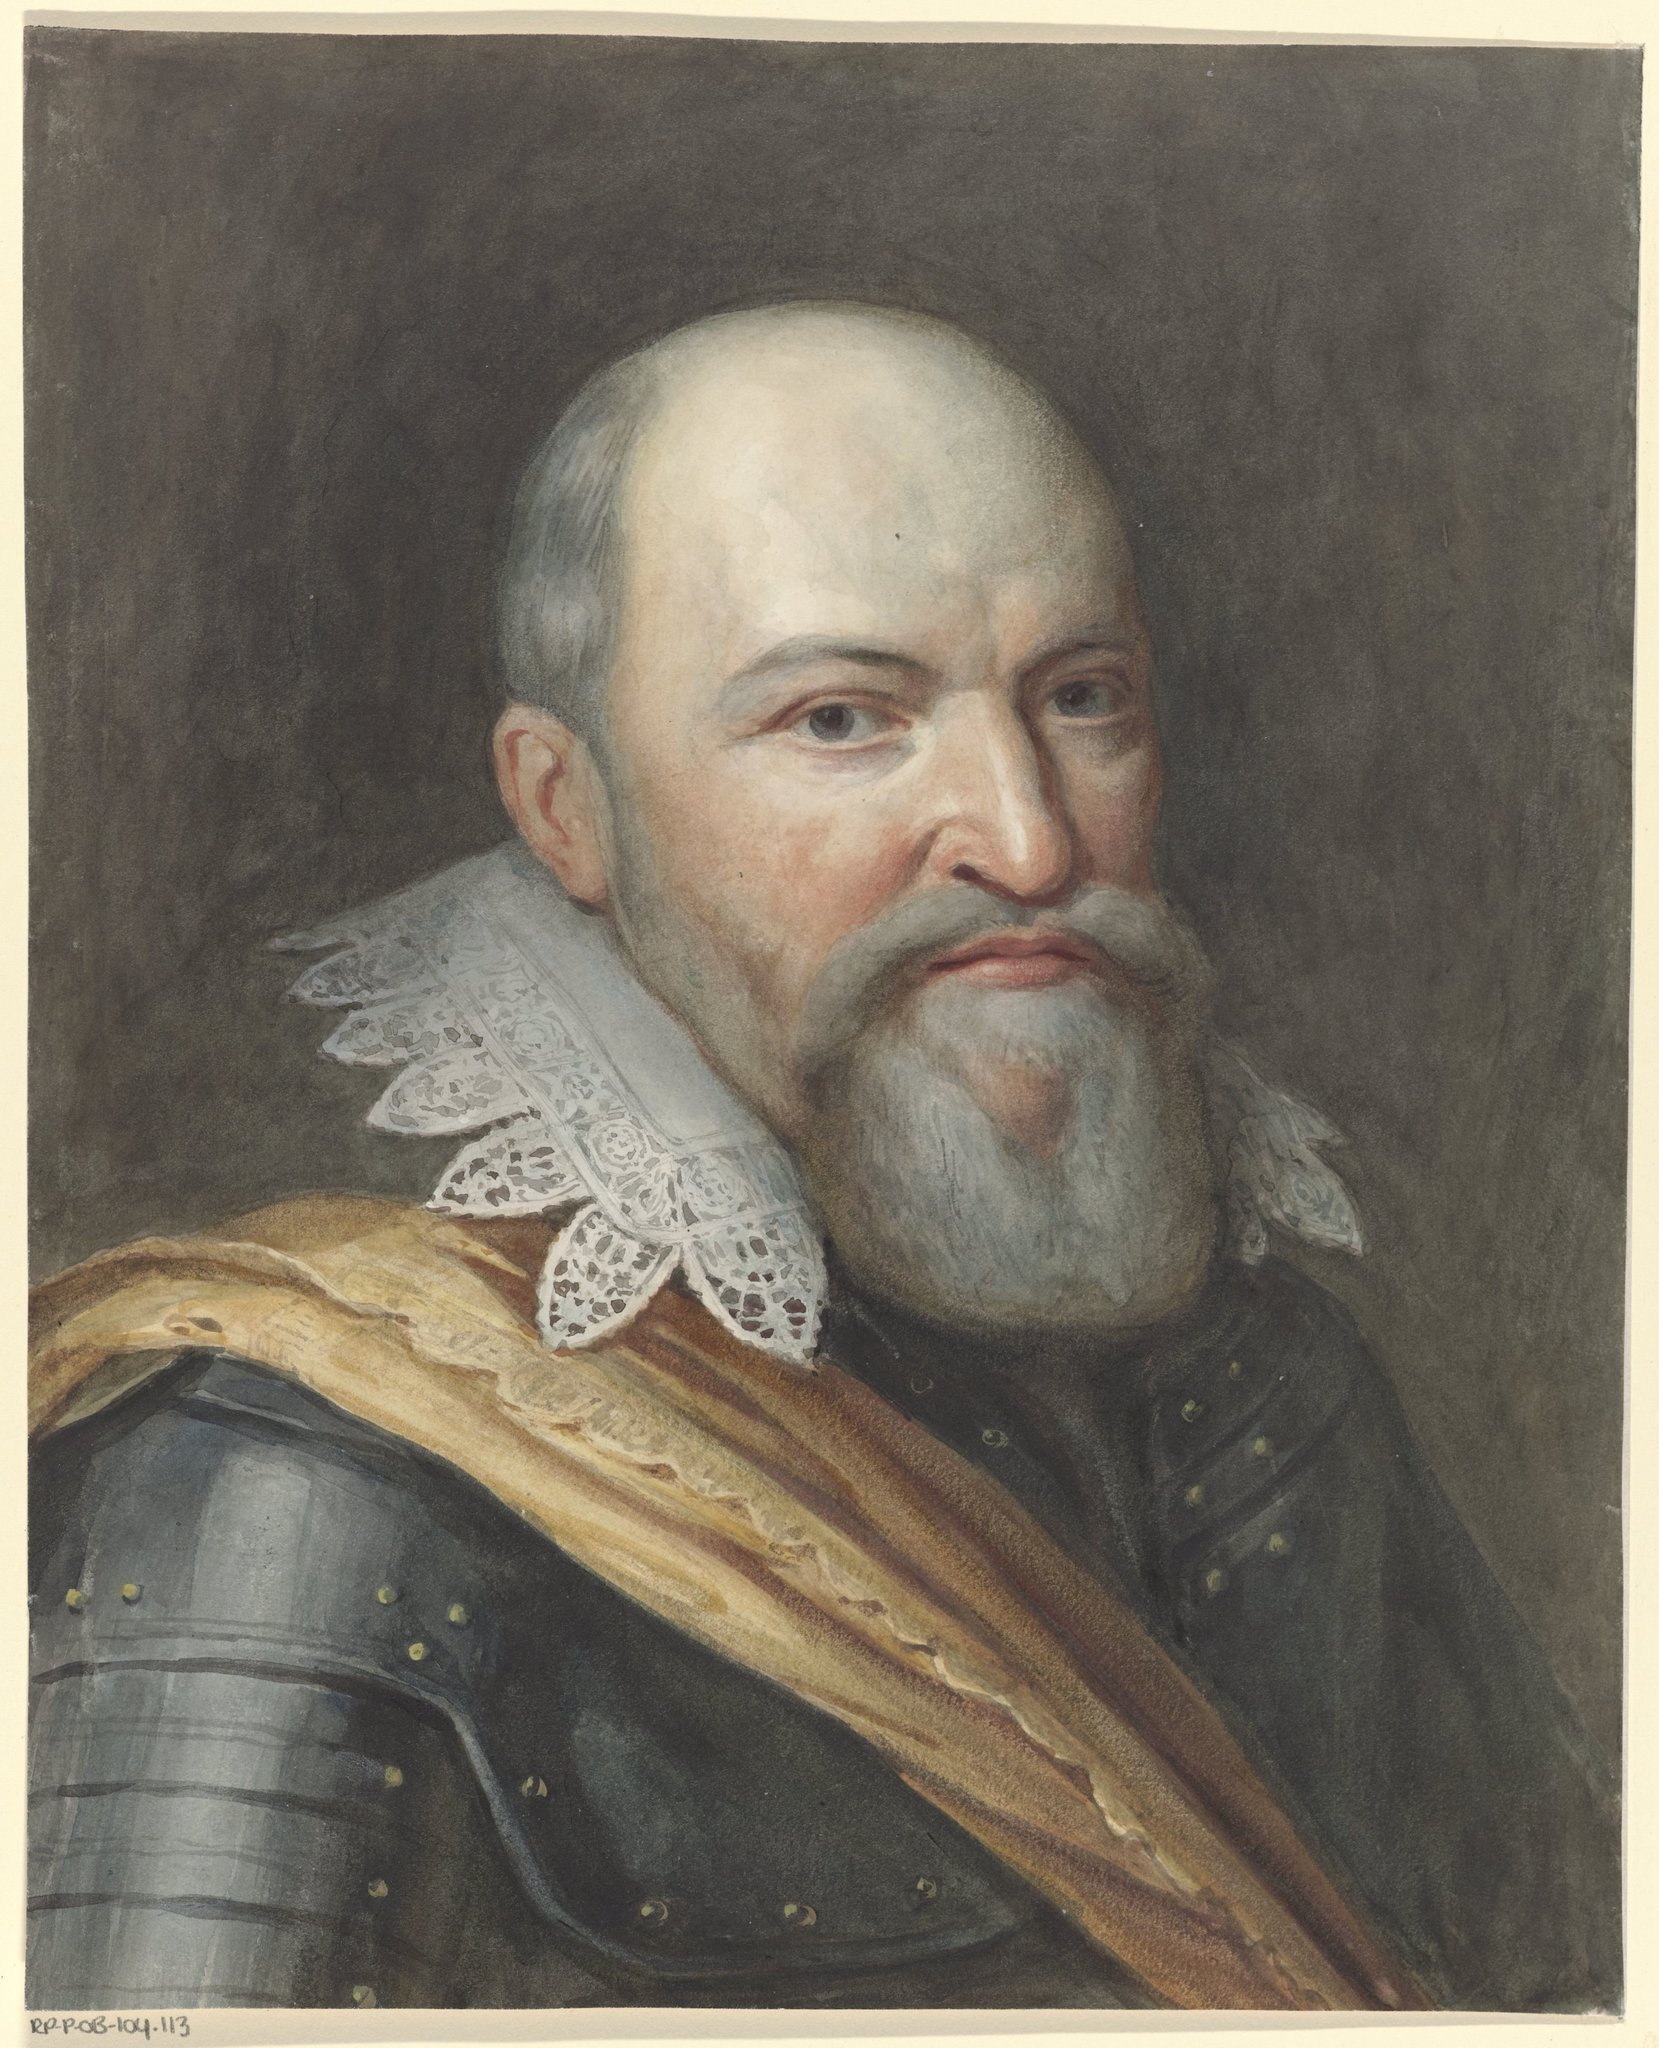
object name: drawing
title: Portret van Justinus, graaf van Nassau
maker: Anonymous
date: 1800-1899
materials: paper, watercolor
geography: low countries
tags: militair, justinus graaf van nassau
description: De hier vermelde titel verwijst naar de hoogst verkregen titel van de geportretteerde, niet per se naar de titel die de geportretteerde op deze voorstelling draagt.